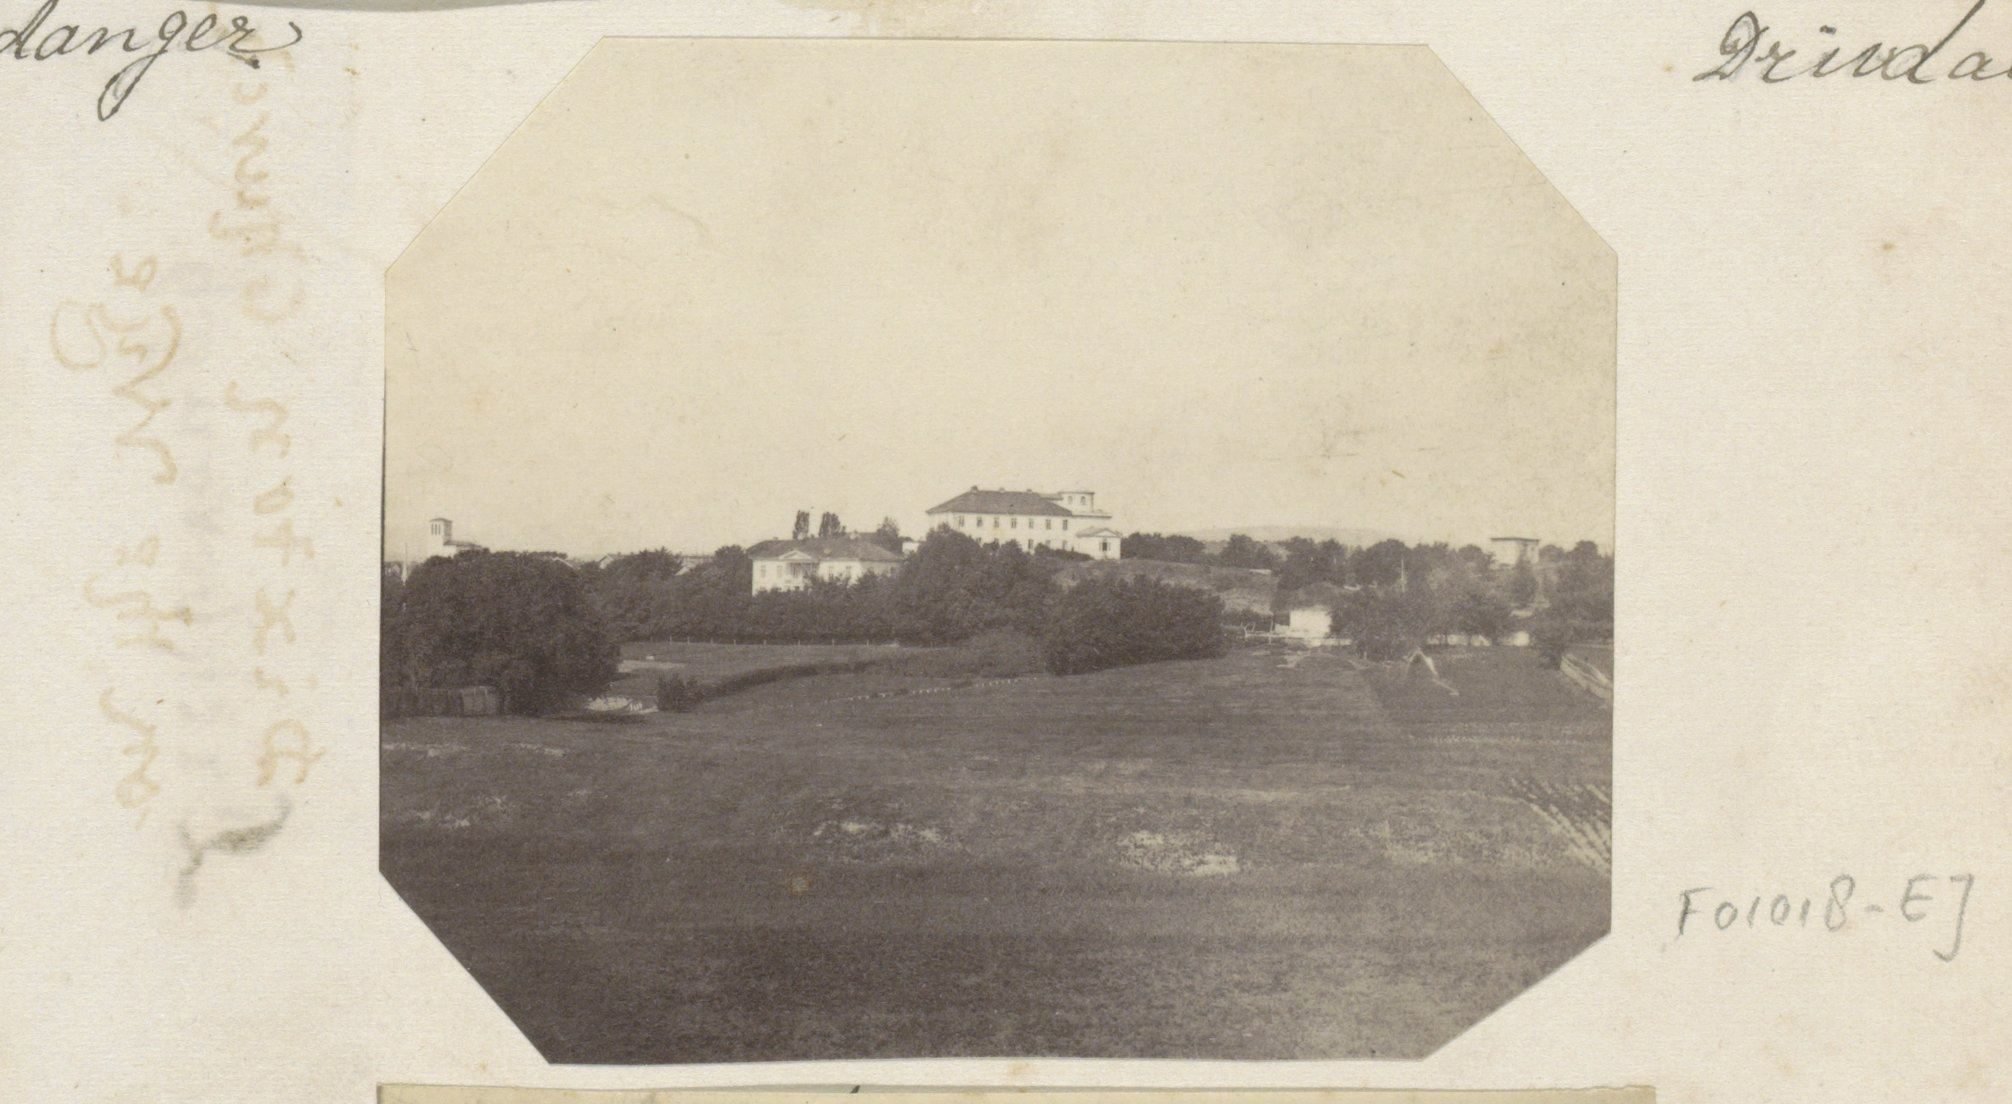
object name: photograph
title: Gezicht op een landhuis, vermoedelijk in Noorwegen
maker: Anonymous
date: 1860-1870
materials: paper, photographic support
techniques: albumen print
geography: norway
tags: meadow, pasture, rural housing, e.g. country-house, villa, cottage, norway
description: Onderdeel van Engels familiealbum met foto's van personen, reizen, cricket en kunstwerken.